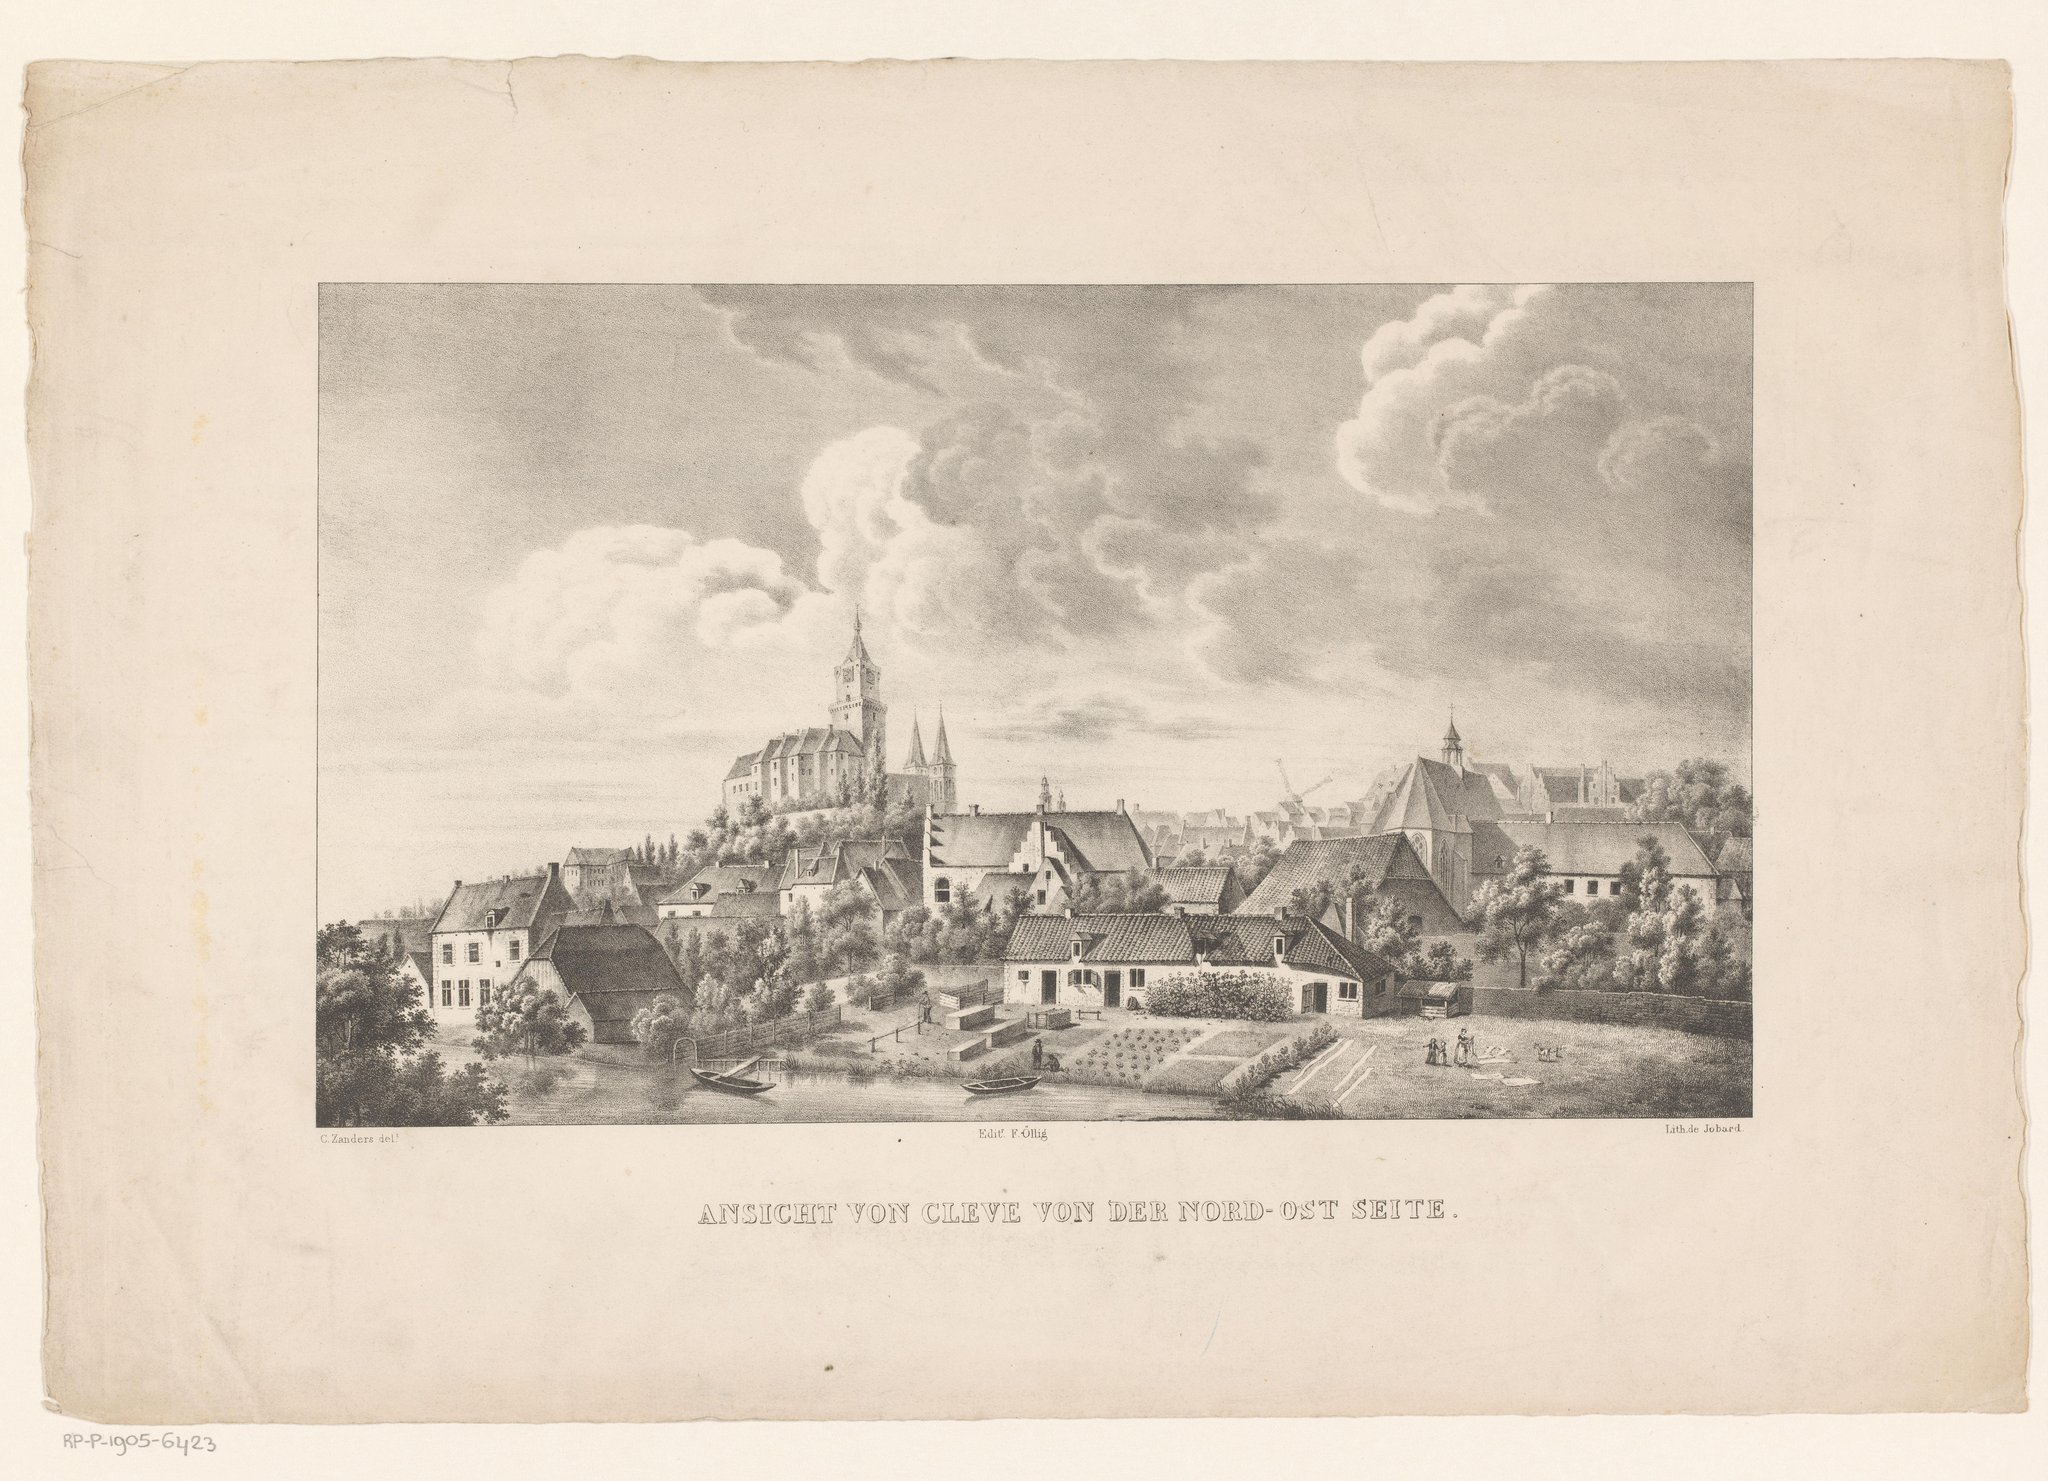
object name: print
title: Ansicht von Cleve von der Nord-Ost seite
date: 1826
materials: paper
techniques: lithograph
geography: cleves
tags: water course, bleaching (laundering), prospect of city, town panorama, silhouette of city, cleves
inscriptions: collector's mark: Lugt 2228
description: Prent verschenen in: Verzameling van twaalf Cleefsche gezigten. Deze publicatie bevat 12 litho's, die in afleveringen verschenen als illustratie bij de tekst. Het Rijksmuseum Amsterdam bezit er hier 7 van.